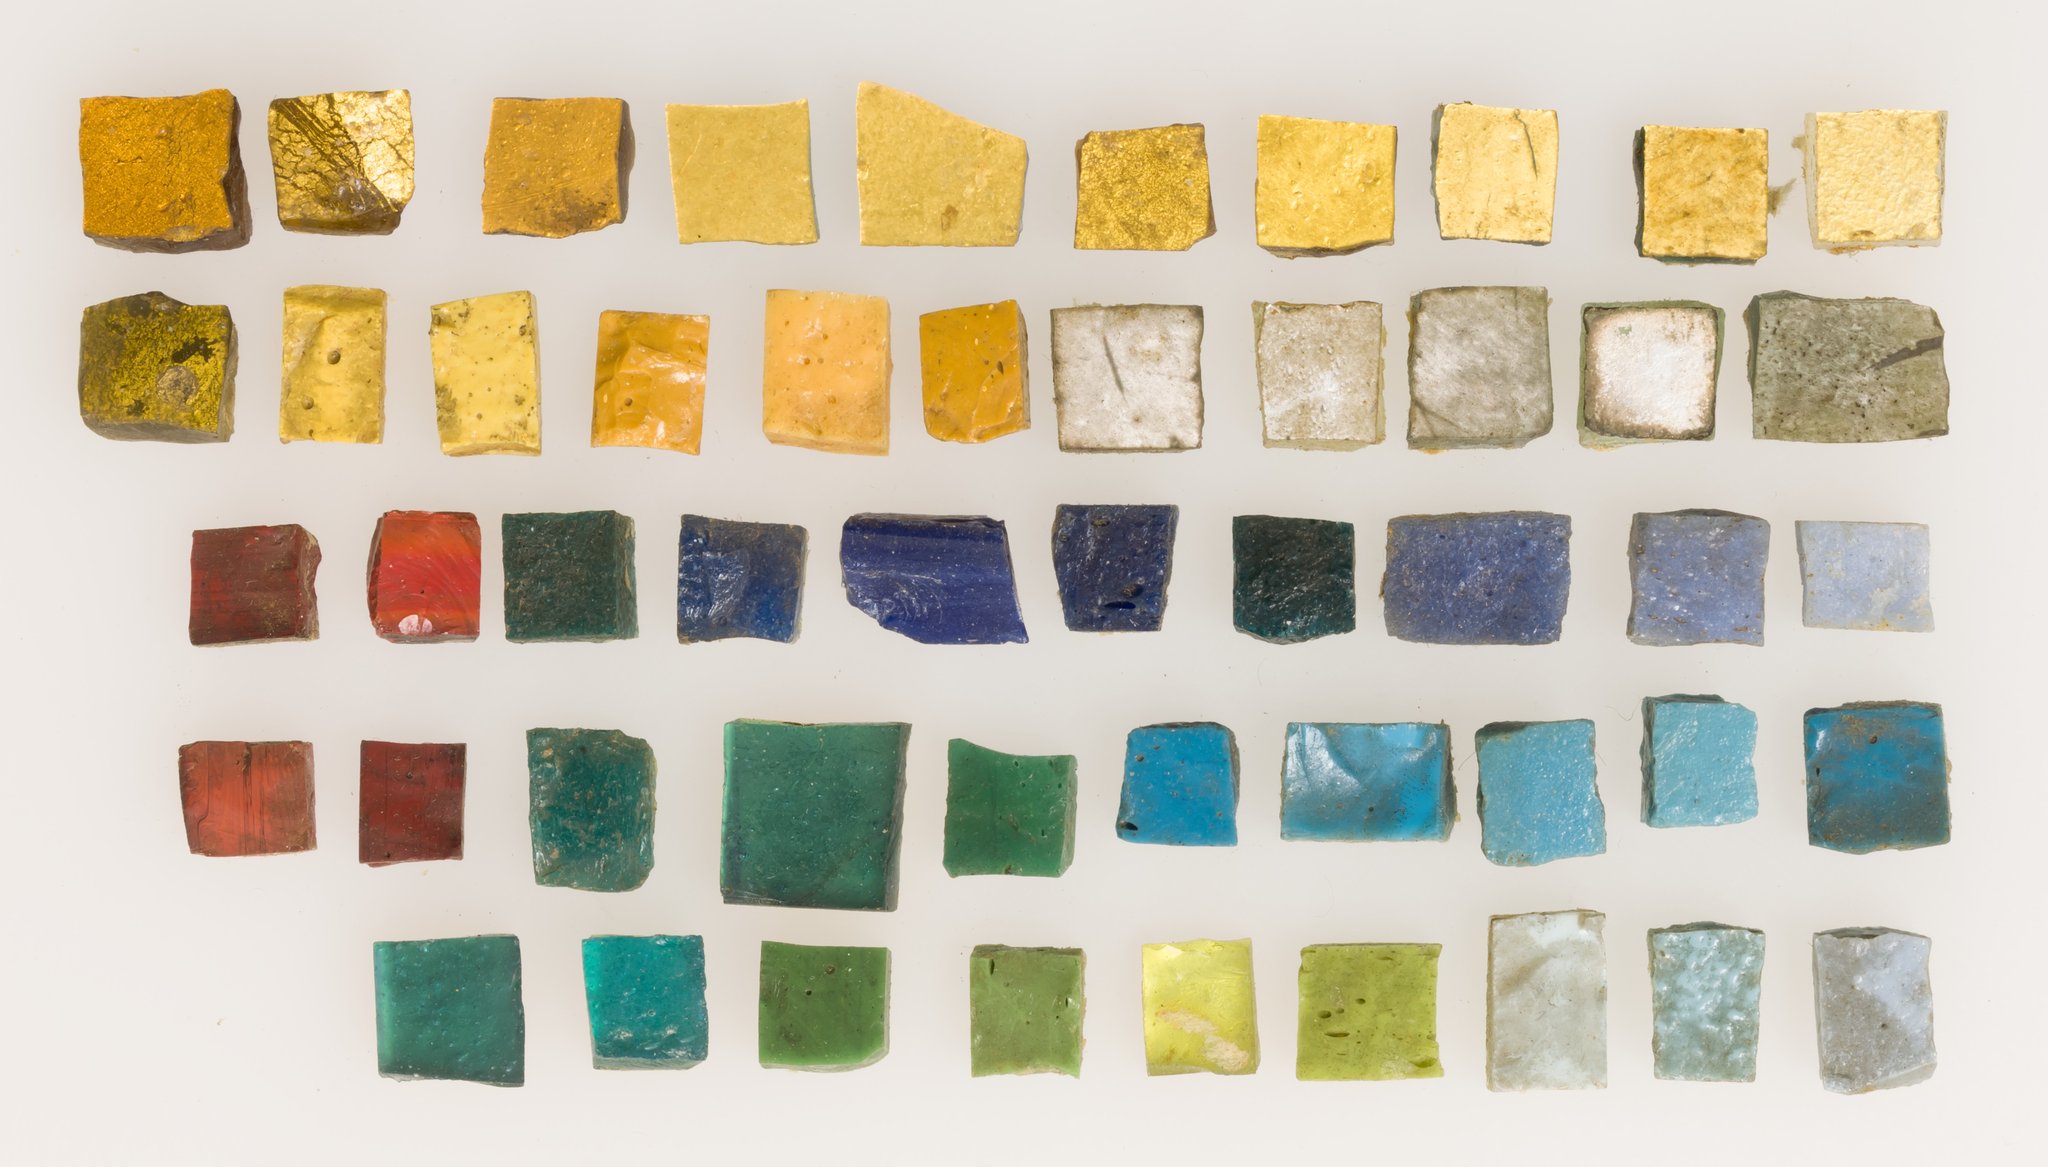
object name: tessera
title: Mosaic Tesserae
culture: byzantine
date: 501-1500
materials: glass, gold, silver